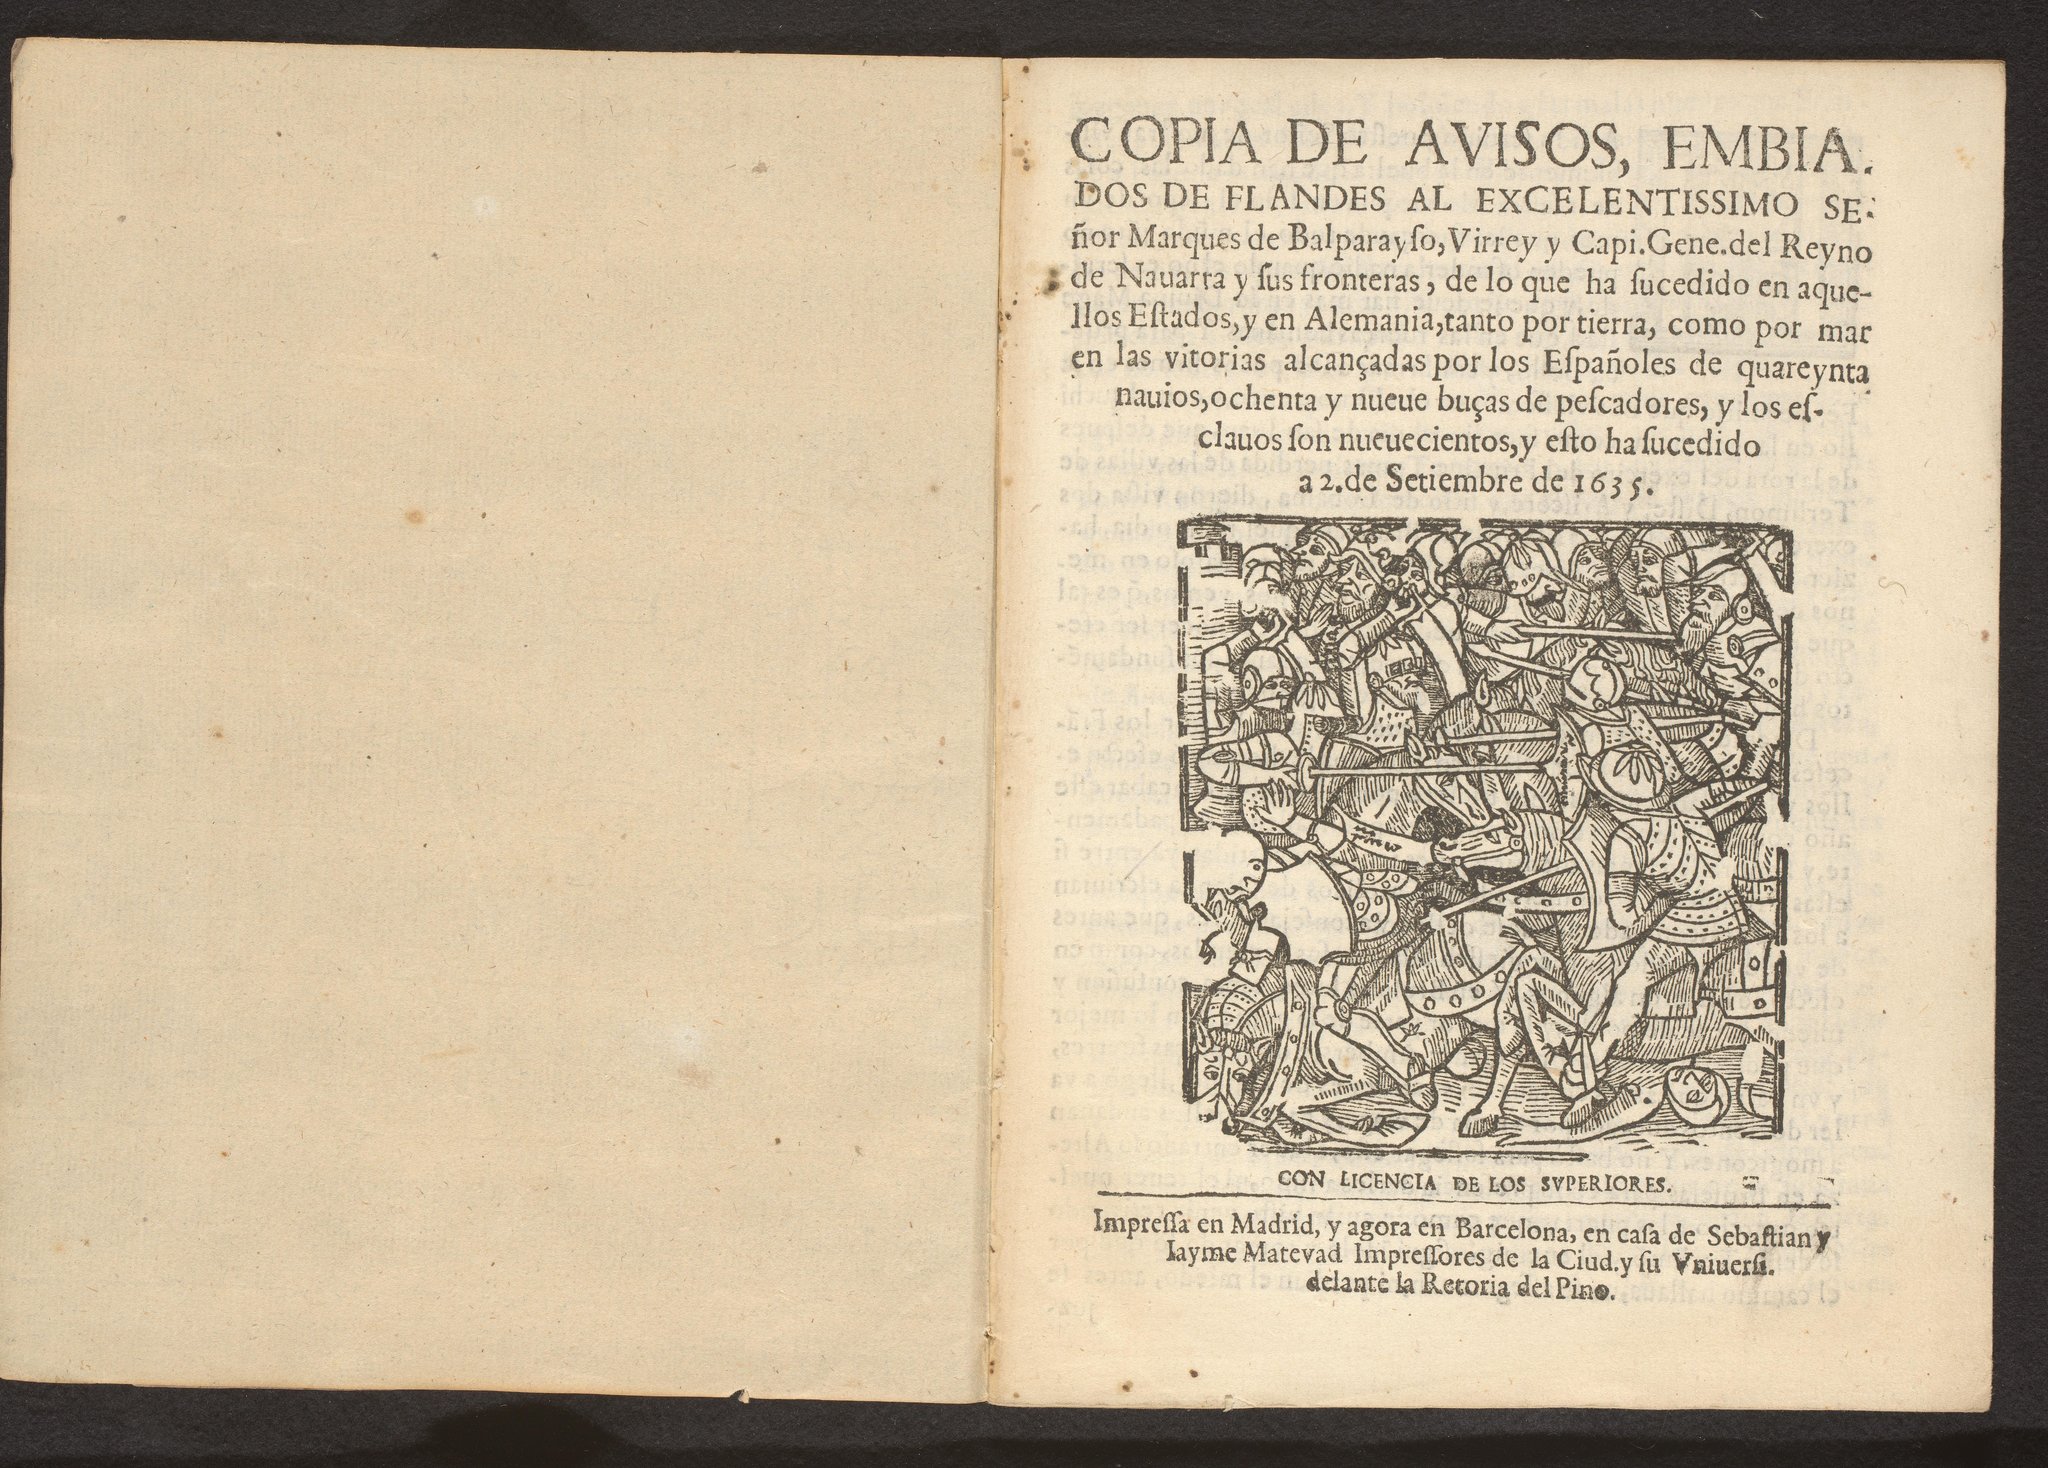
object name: brochure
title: Copia de Avisos, embiados de Flandes al Excelentissimo Senor Marques de Balparayso (...)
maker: sebastian matevad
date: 1635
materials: paper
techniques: printing, sewing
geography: madrid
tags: spain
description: Acht bedrukte, niet genummerde pp in moderne paarse papieren omslag. Spaanstalig.